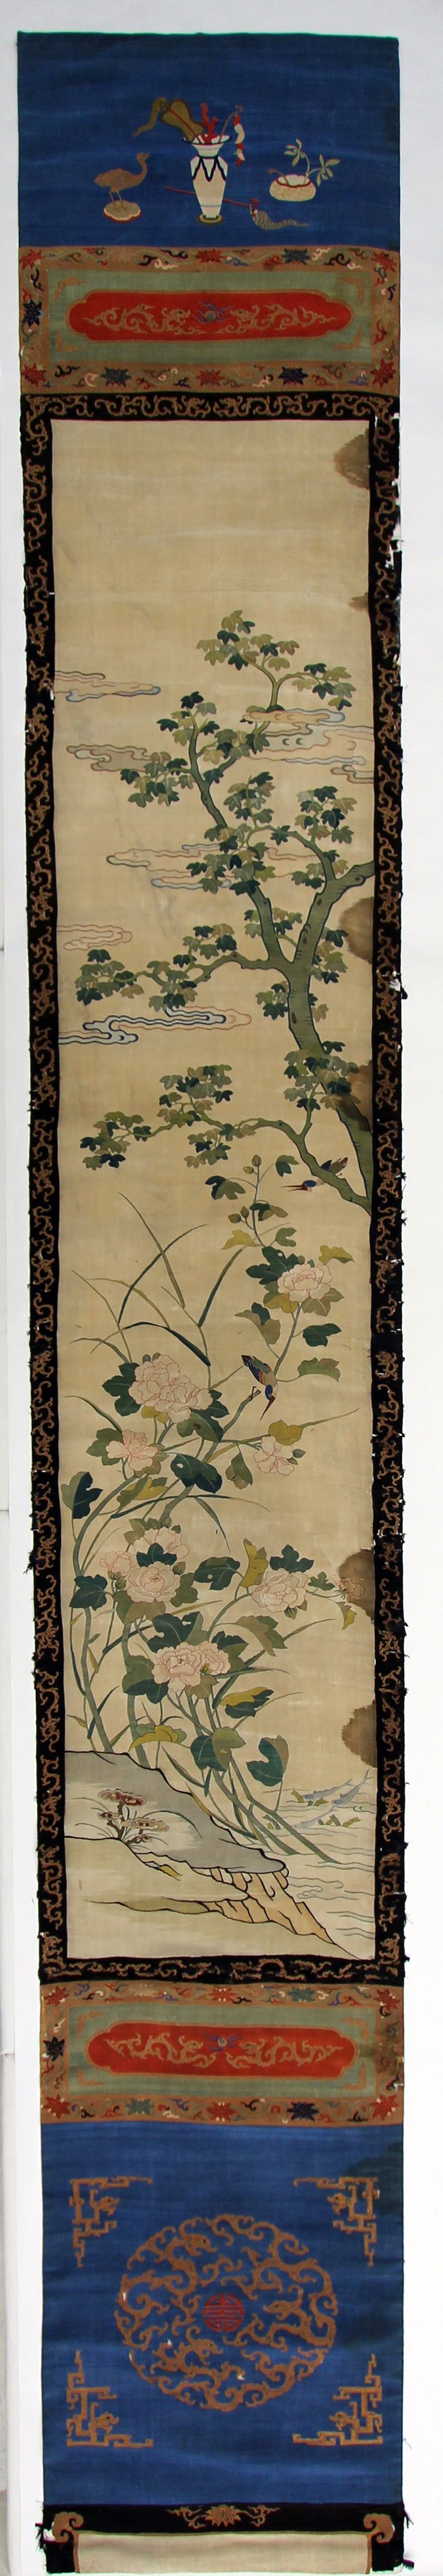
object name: picture, tapestry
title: Tapestry Picture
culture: chinese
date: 1767-1833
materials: metal thread, silk